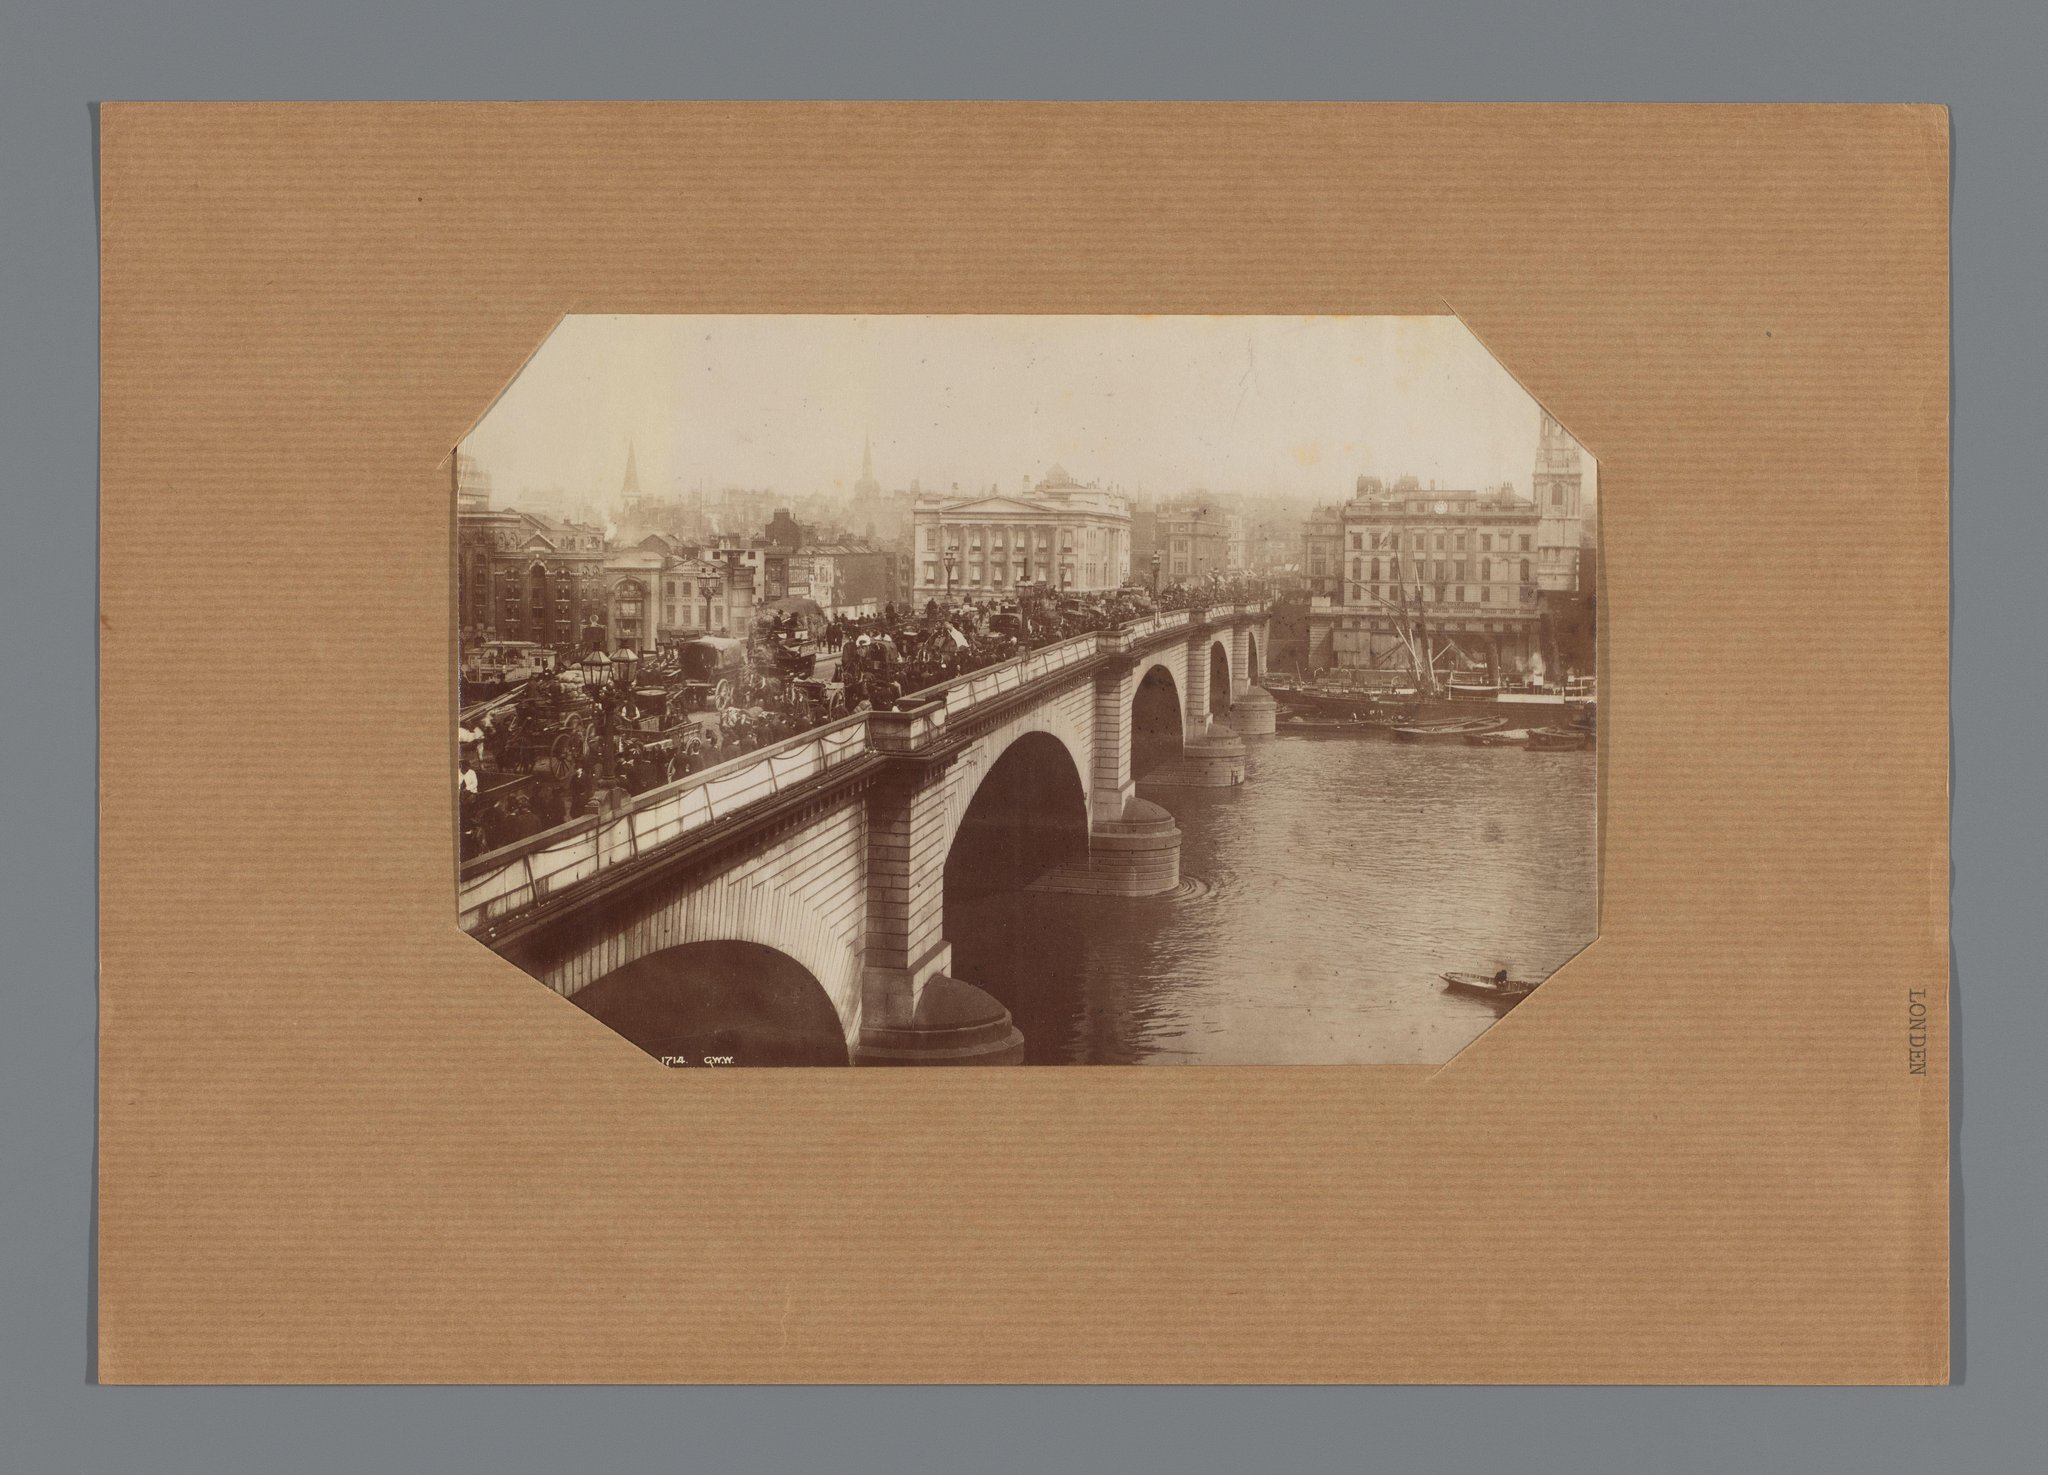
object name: photograph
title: Londen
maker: Anonymous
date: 1850-1900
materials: photographic support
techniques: albumen print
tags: london